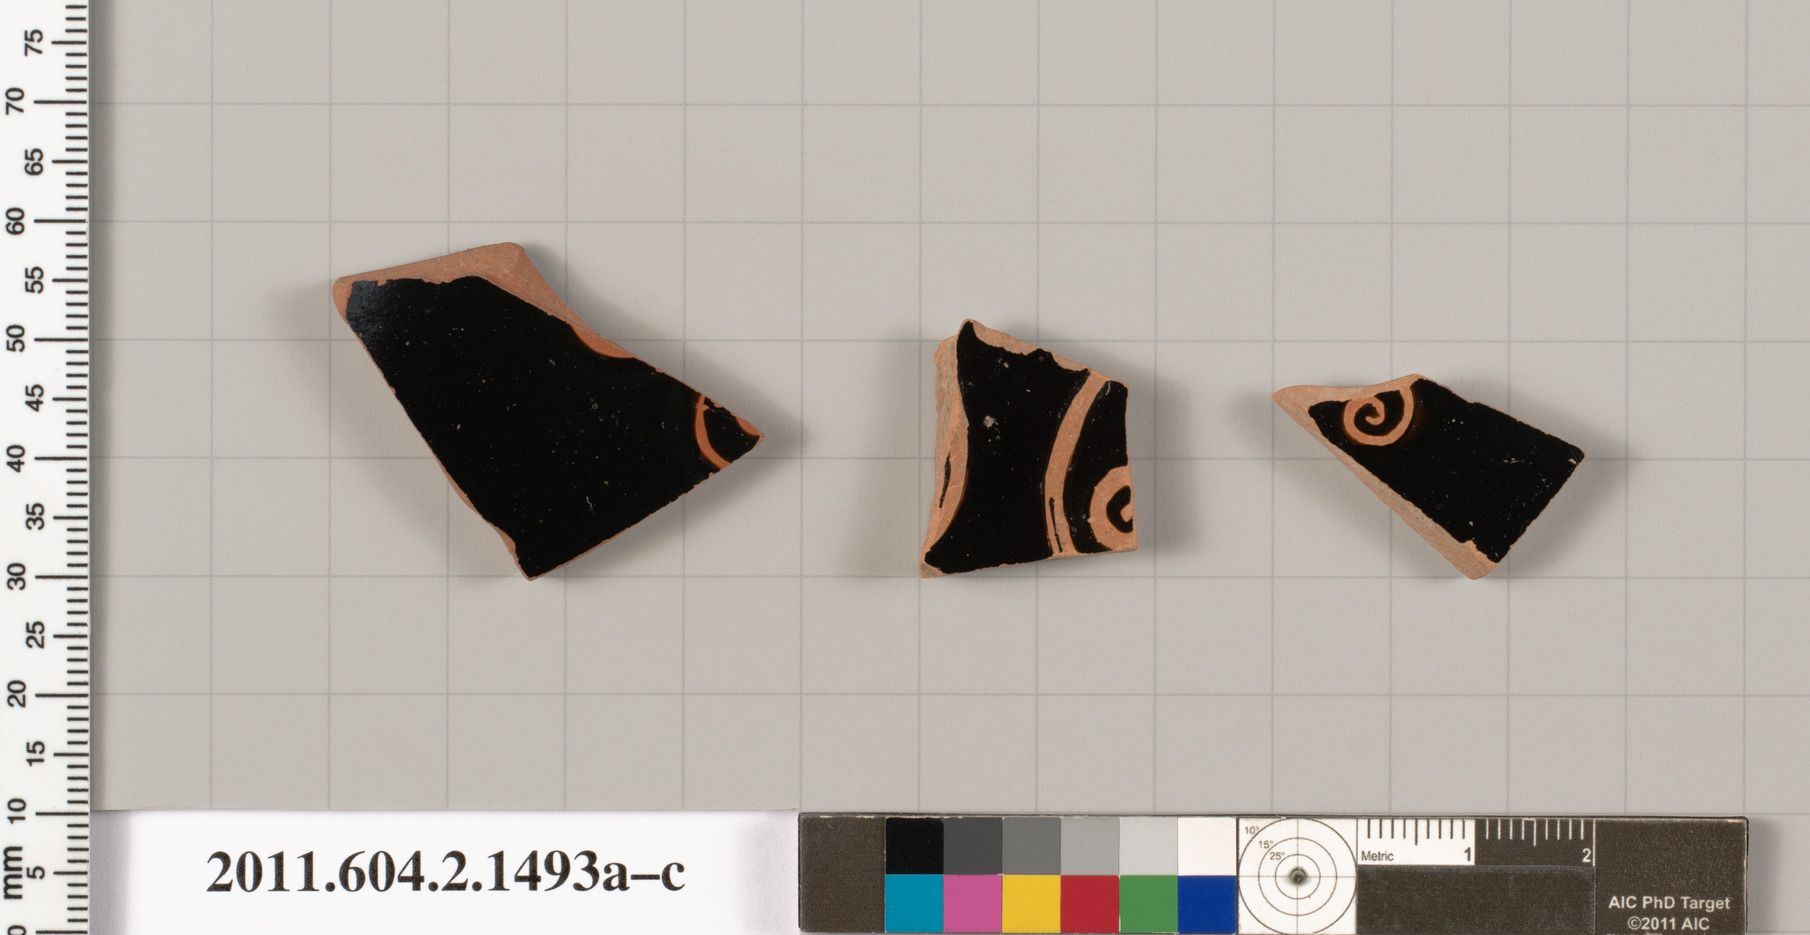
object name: skyphos fragment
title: Terracotta fragments of skyphoi (deep drinking cups)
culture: greek, attic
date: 475-440 BCE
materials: terracotta